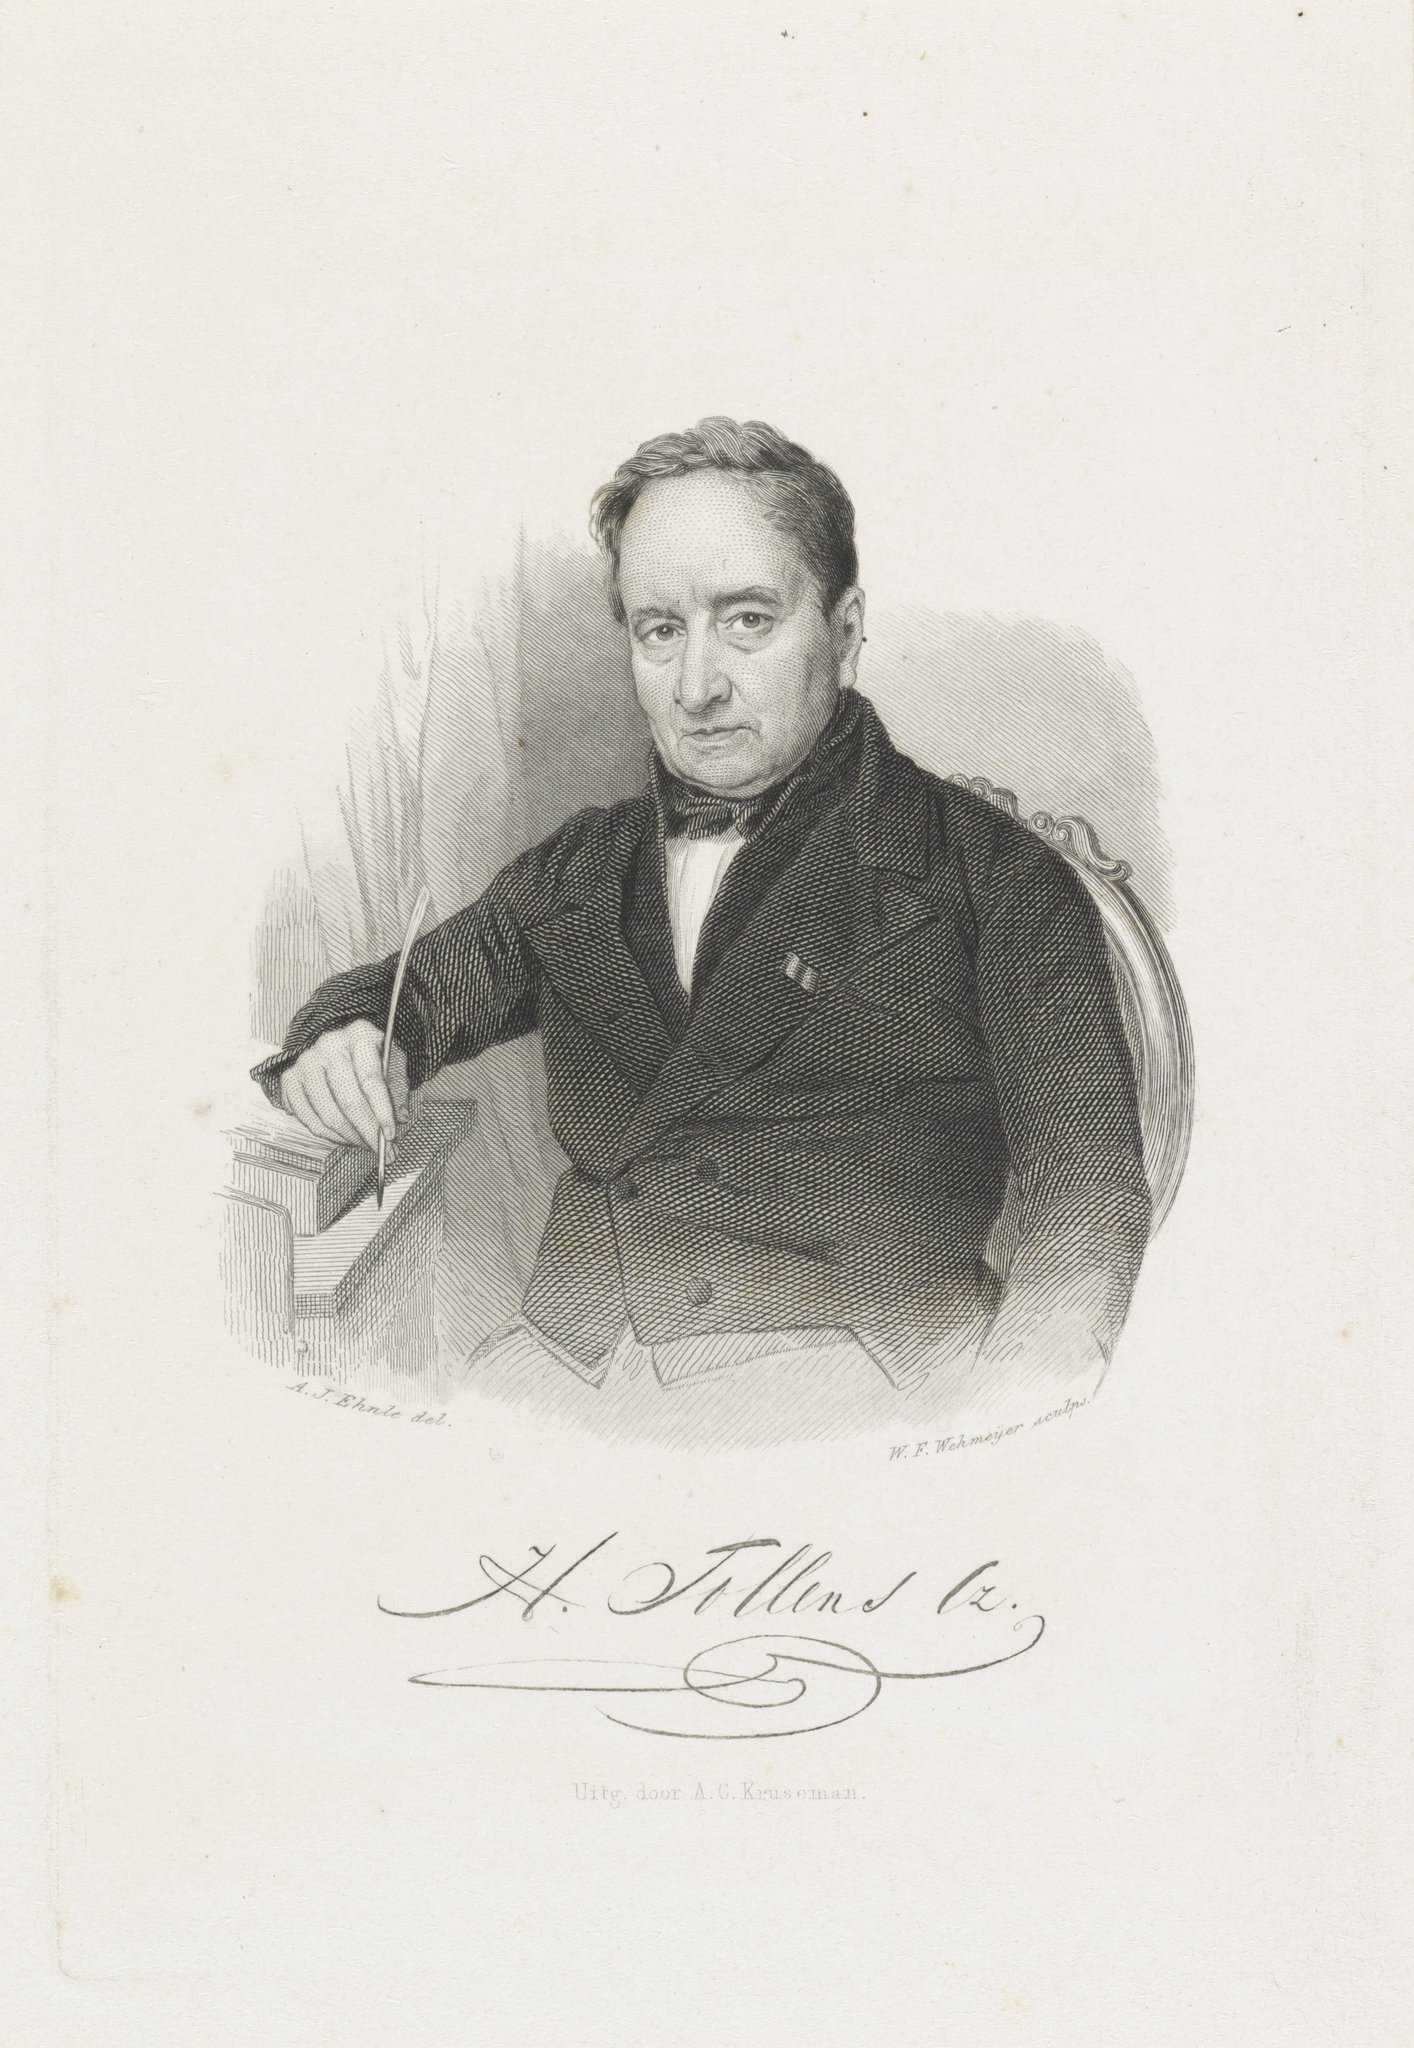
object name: print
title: Portret van Hendrik Tollens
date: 1834-1856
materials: paper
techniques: engraving, etching, roulette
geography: haarlem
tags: rotterdam, hendrik tollens, adult man, historical persons, chair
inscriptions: collector's mark: Lugt 2228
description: Portret van Hendrik Tollens, dichter. Hij zit op een stoel voor een gordijn en houdt schrijfgerei in zijn rechterhand. Zijn rechterarm rust op een opengeslagen boek. Onder de voorstelling bevindt zich de signatuur van de geportretteerde.